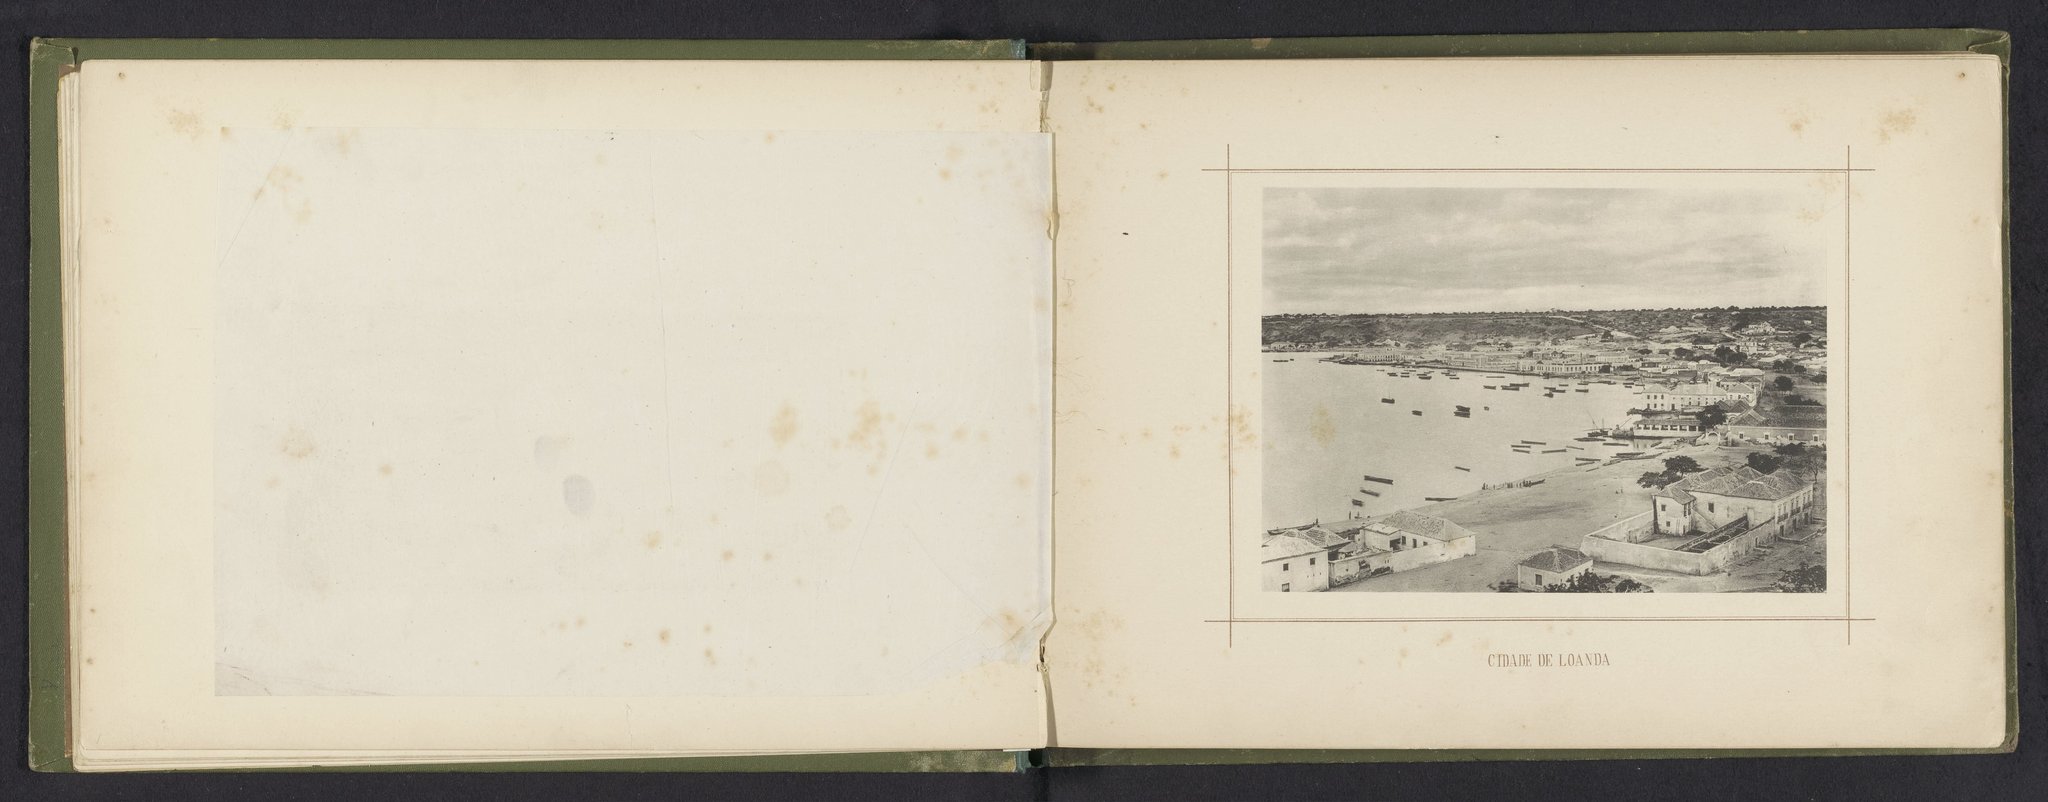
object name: photomechanical print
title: Cidade de Loanda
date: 1876-1886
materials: paper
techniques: photograph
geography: luanda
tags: gulf, bay, city-view in general; 'veduta'